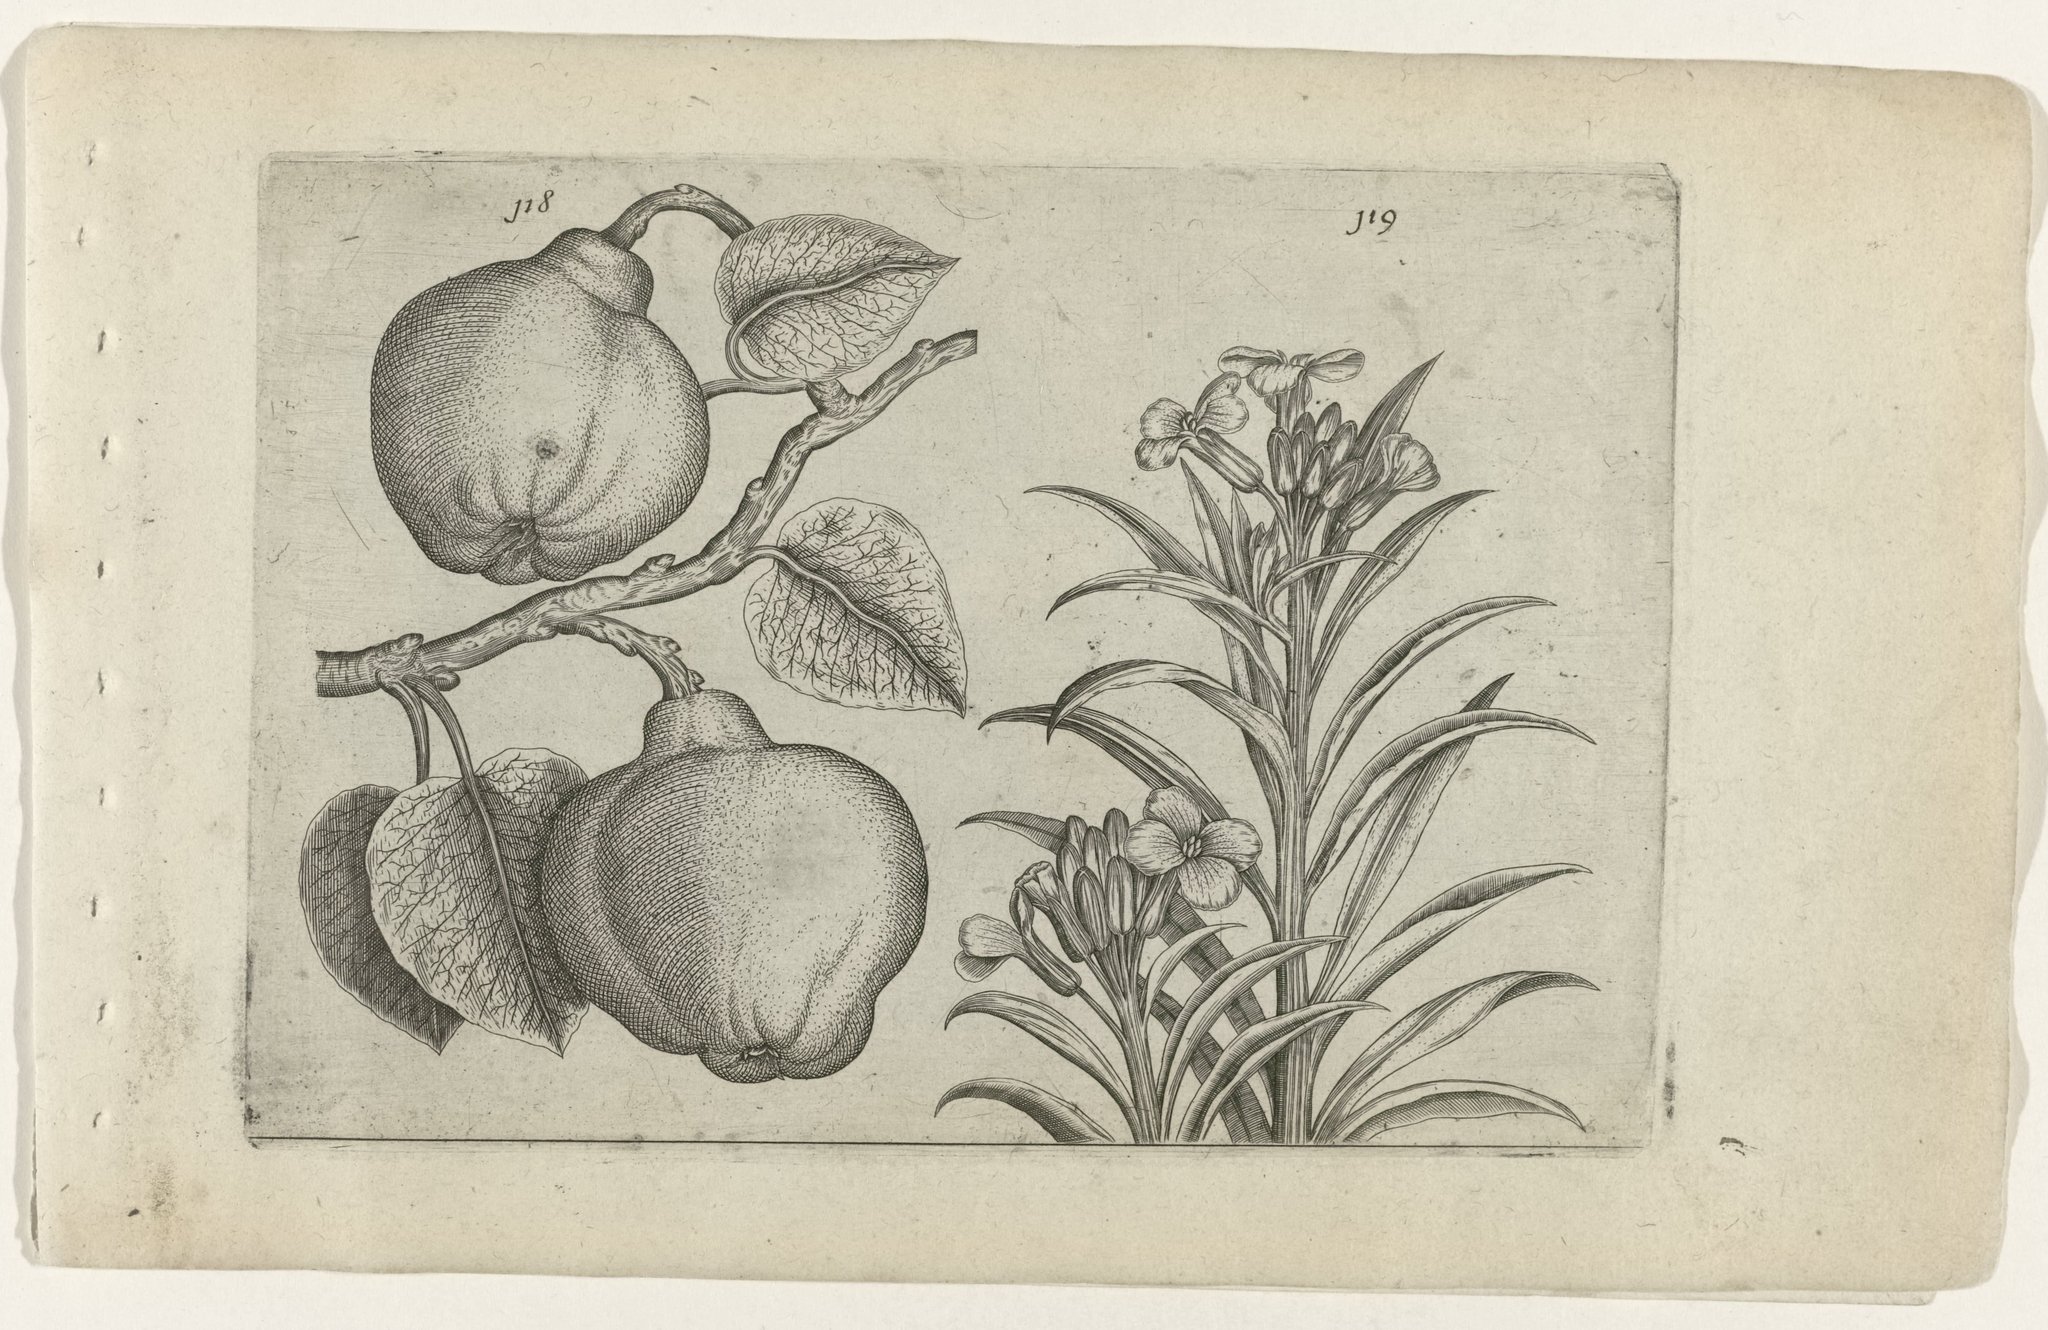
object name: print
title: Kweepeer en muurbloem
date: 1600-1604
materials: paper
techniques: engraving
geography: cologne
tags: fruits: quince, flowers: wallflower, botany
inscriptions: collector's mark: Lugt 2228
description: De prenten RP-P-2012-24-1 t/m 61 waren oorspronkelijk als serie samengebonden. De naaigaten op de bladen zijn nog zichtbaar. Het betreft de reeks getiteld: Cognoscite lilia, bestaande uit een titelprent en 60 gravures met 119 genummerde weergaven van planten, bloemen en vruchten, versierd met rinceaux en kleine voorstellingen van dieren. Het gaat om proefdrukken van deze reeks gravures, voor de opschriften en, deels, voor de nummering. Op enkele prenten zijn de nummers met de hand aangebracht. Op de titelprent ontbreekt nog het adres van Crispijn de Passe en Hans Woutneel. De titel is hoogstwaarschijnlijk gegraveerd door Matthias Quad. Deze werkte voor De Passe in Keulen tot 1604. De reeks moet in dit jaar of daarvoor tot stand zijn gebracht. In ieder geval voor 1608, aangezien de uitgever Hans Woutneel in of voor dat jaar overleed. In ieder geval voor 1608, aangezien de uitgever Hans Woutneel in of voor dat jaar overleed. De gravures worden door Ilja Veldman en Anthony Griffiths beschouwd als eigenhandig werk van Crispijn de Passe I. Een van de prenten uit de reeks ontbreekt (nr 21-22) en is vervangen door een ingekleurde afdruk uit een latere uitgave (RP-P-2012-24-61), die onder de titel Altera Pars is opgenomen in de Hortus Floridus, uitgegeven door Crispijn de Passe I en die verder bestaat uit platen van Crispijn de Passe II. De prenten afkomstig uit deze uitgave zijn op de verso voorzien van tekst in boekdruk. De vervangende prent maakte geen deel uit van de gebonden serie aangezien dit blad als enige geen naaigaten heeft. Een deel van de planten, bloemen en vruchten in de Cognoscite lilia gaat terug of is gebaseerd op een reeks aquarellen van Jacques LeMoyne uit circa 1580 en uit 1585, nu in het Victoria and Albert Museum en de British Museum (zie P. Hulton, Jacques LeMoyne, Londen 1977, dl 1, p. 156-162 en p. 165-173).